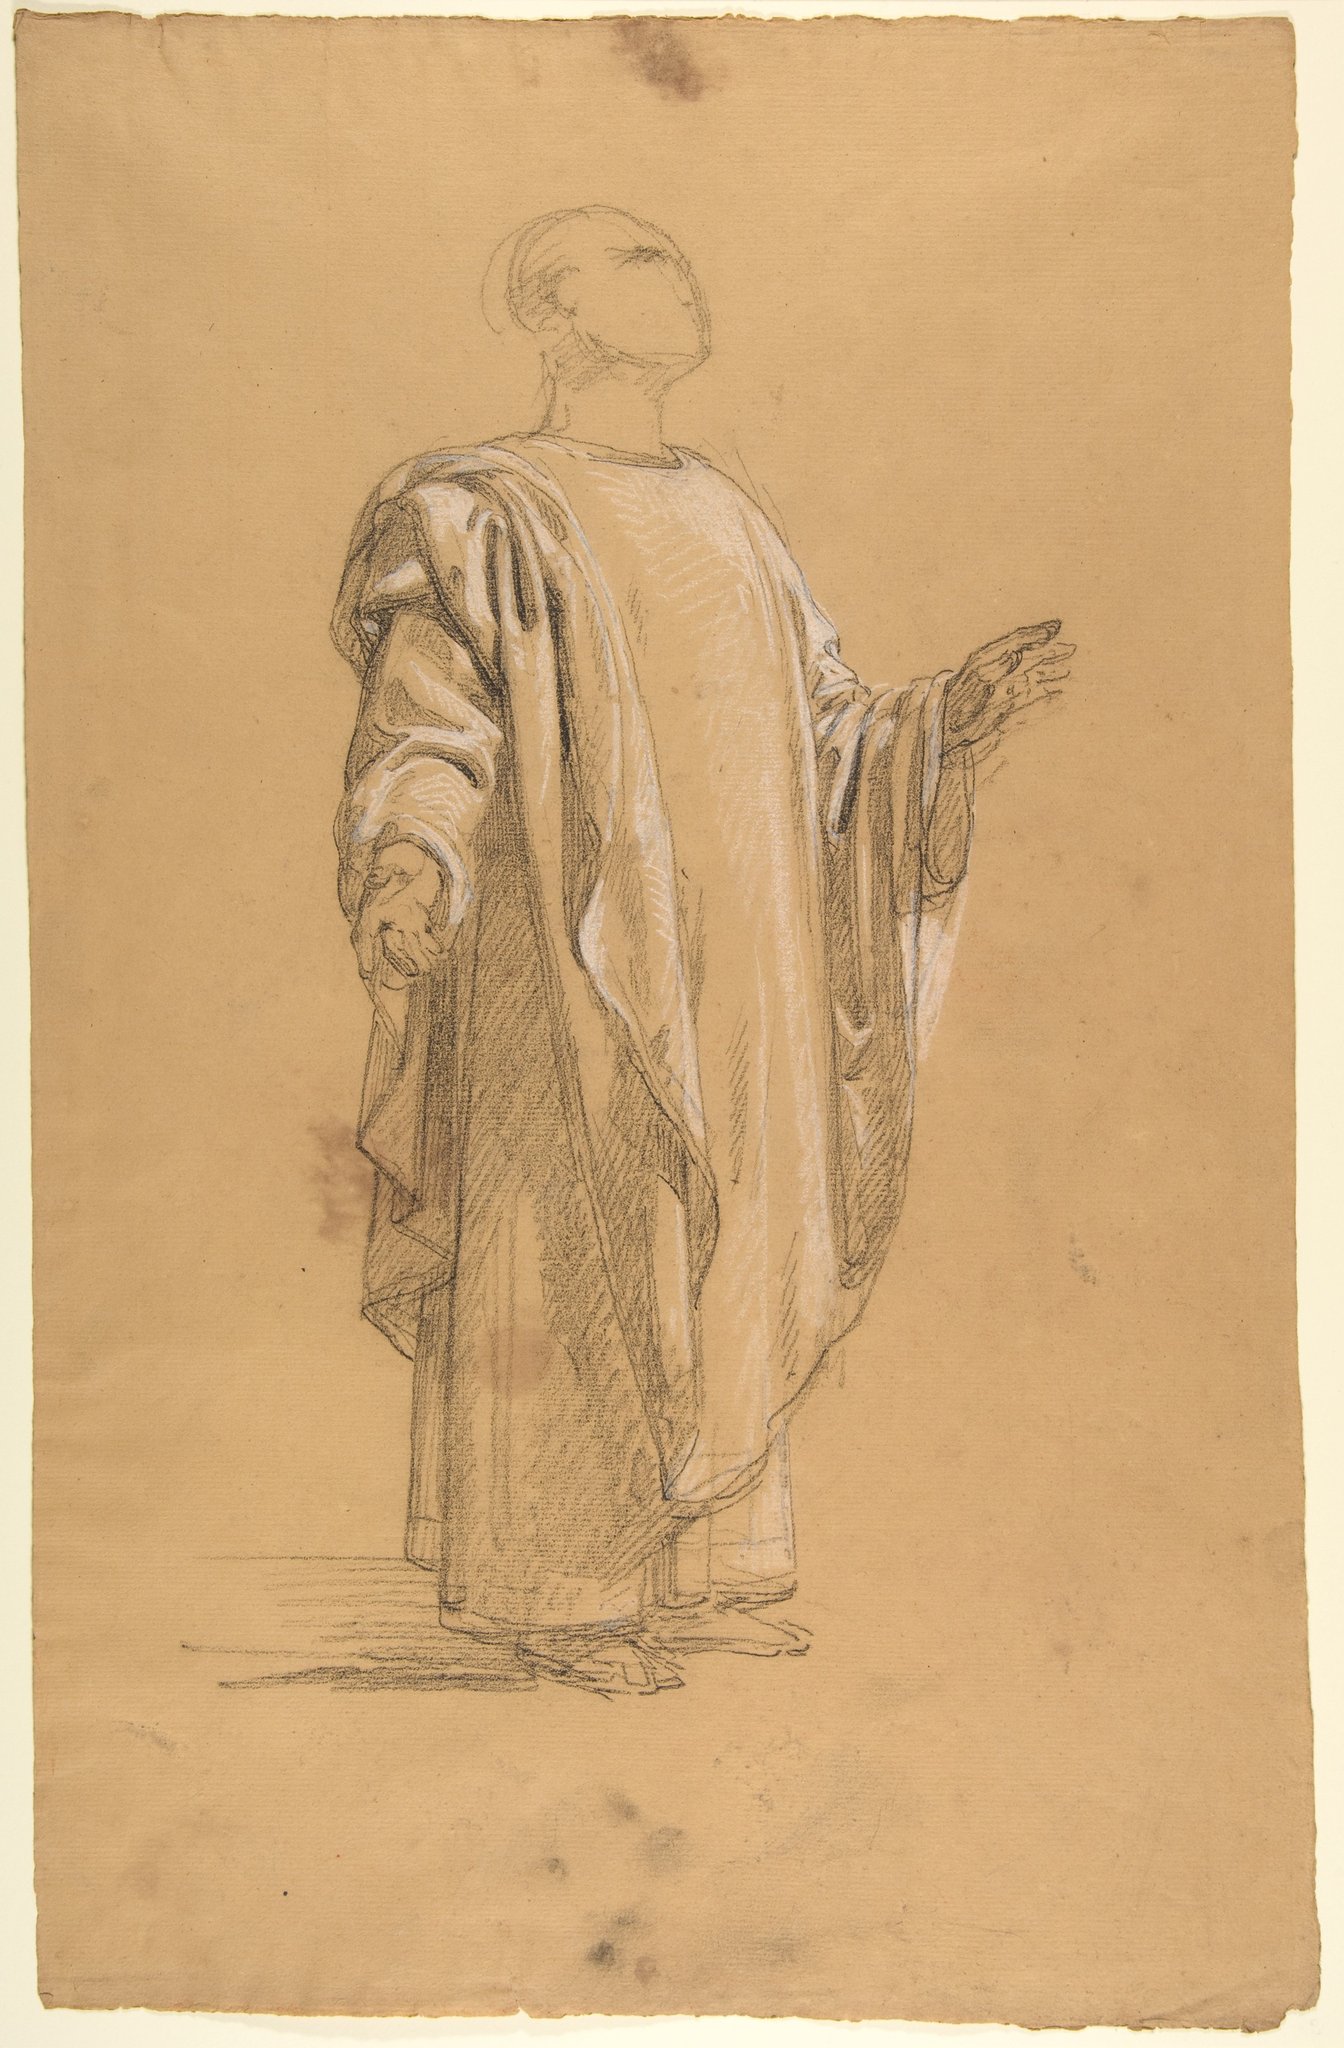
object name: drawing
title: Saint Remi (lower register; study for wall paintings in the Chapel of Saint Remi, Sainte-Clotilde, Paris, 1858)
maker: isidore pils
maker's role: artist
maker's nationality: french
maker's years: 1813-1875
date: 1801-1900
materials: chalk, paper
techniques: heightening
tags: saints